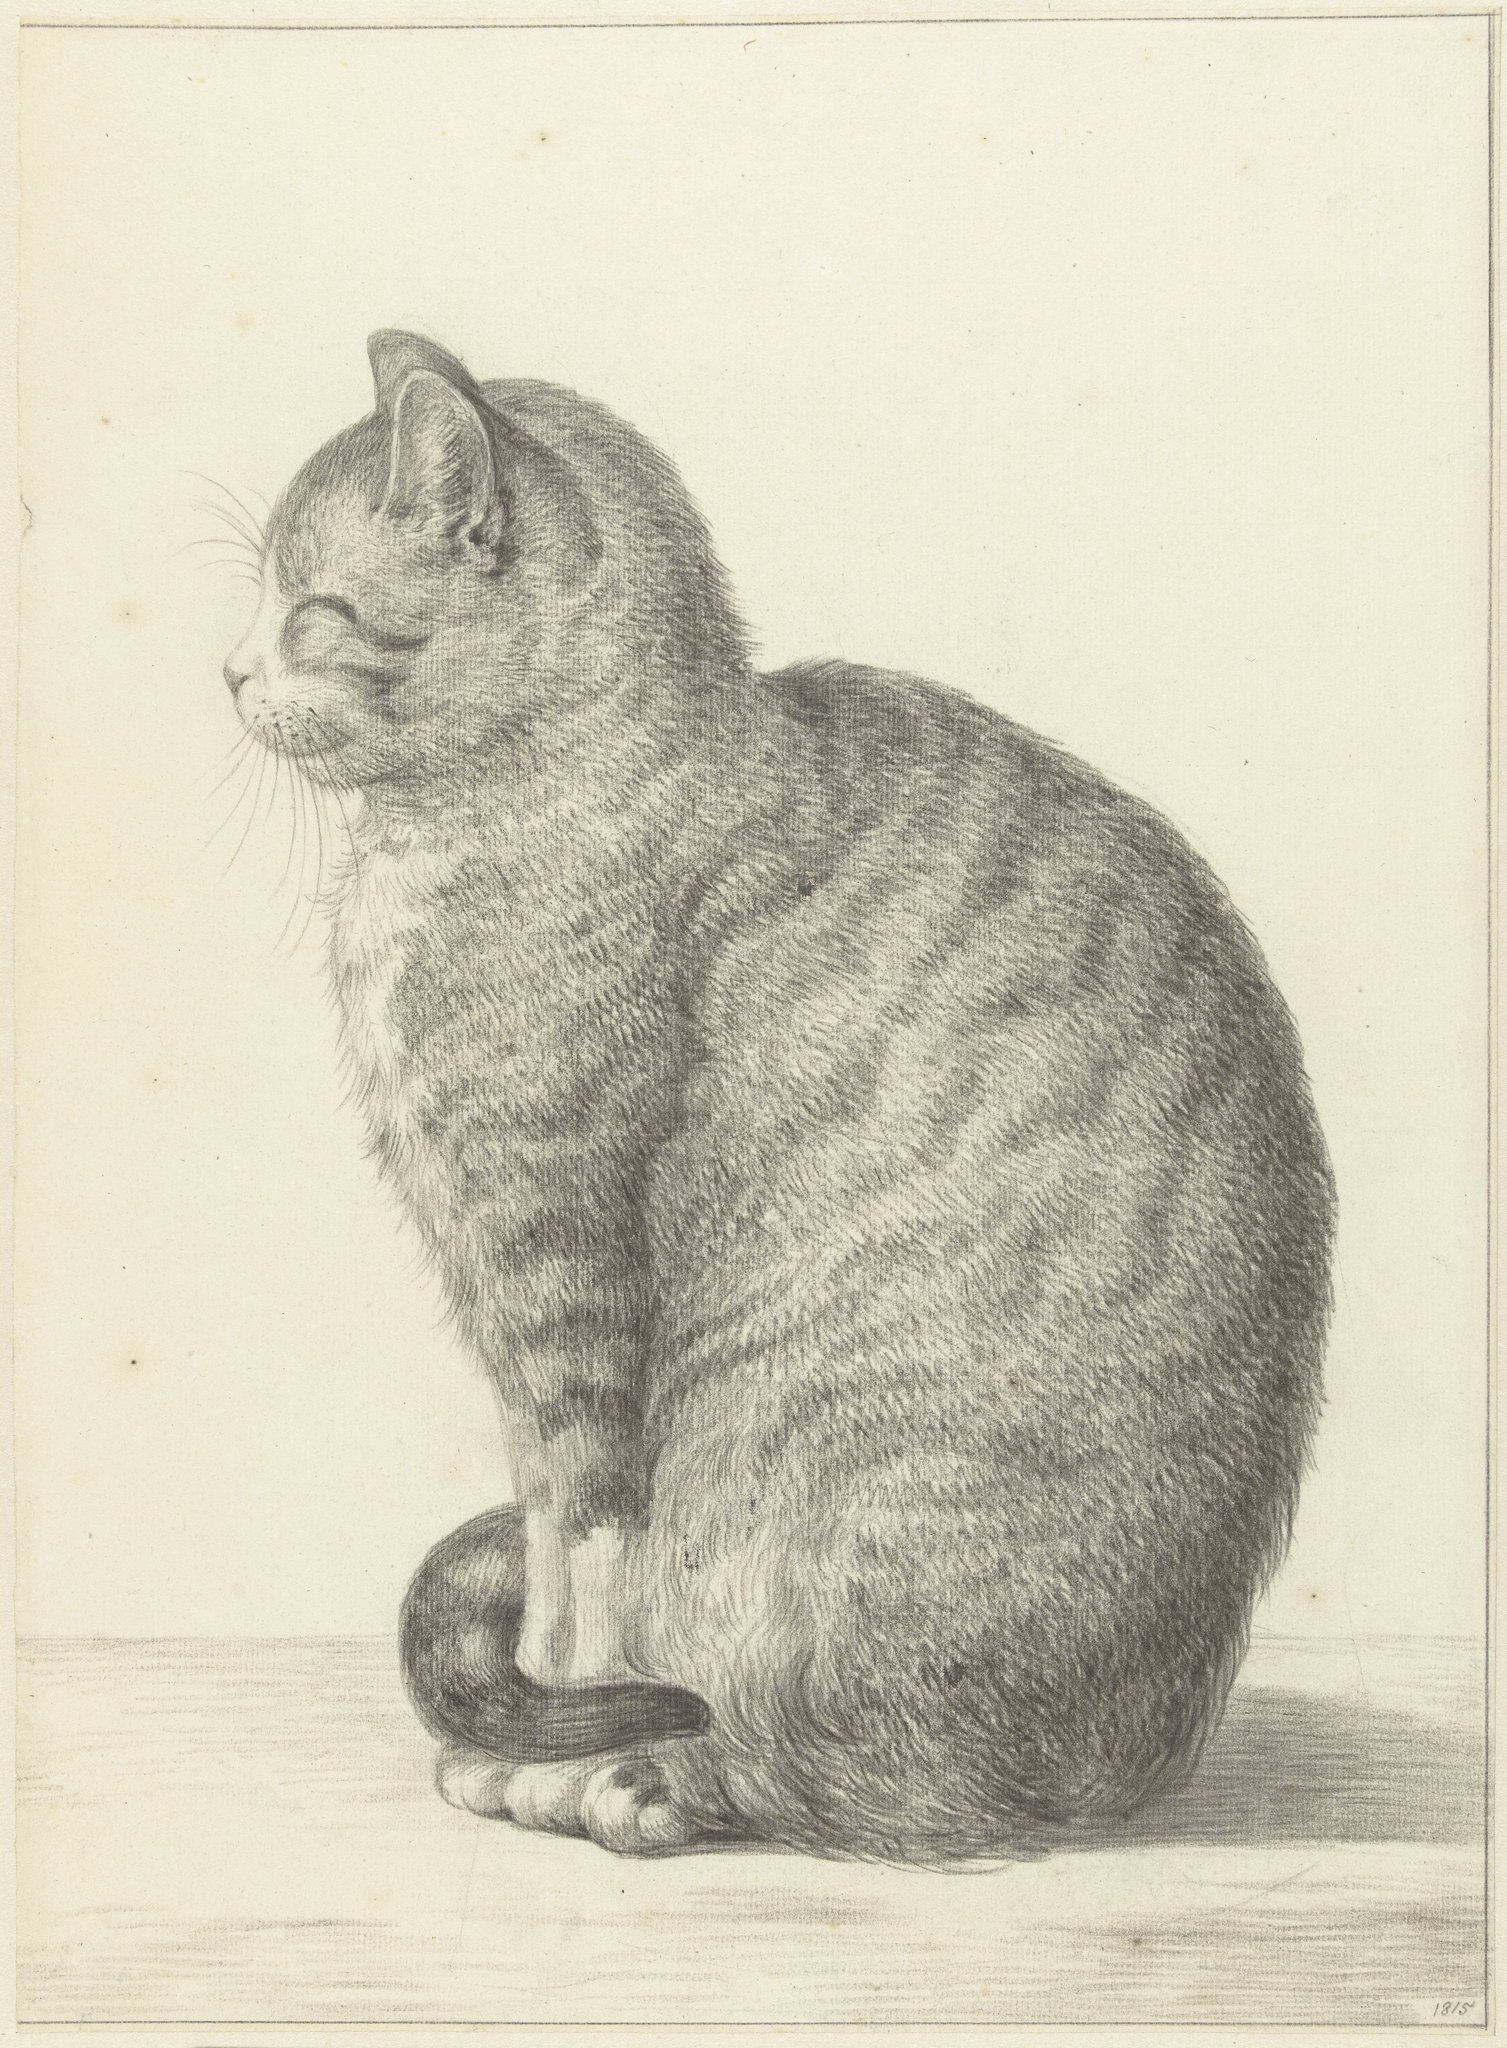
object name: drawing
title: Zittende kat, naar links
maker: jean bernard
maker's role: draughtsman, print maker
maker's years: 1765-1833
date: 1815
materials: chalk, paper, pencil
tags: cat